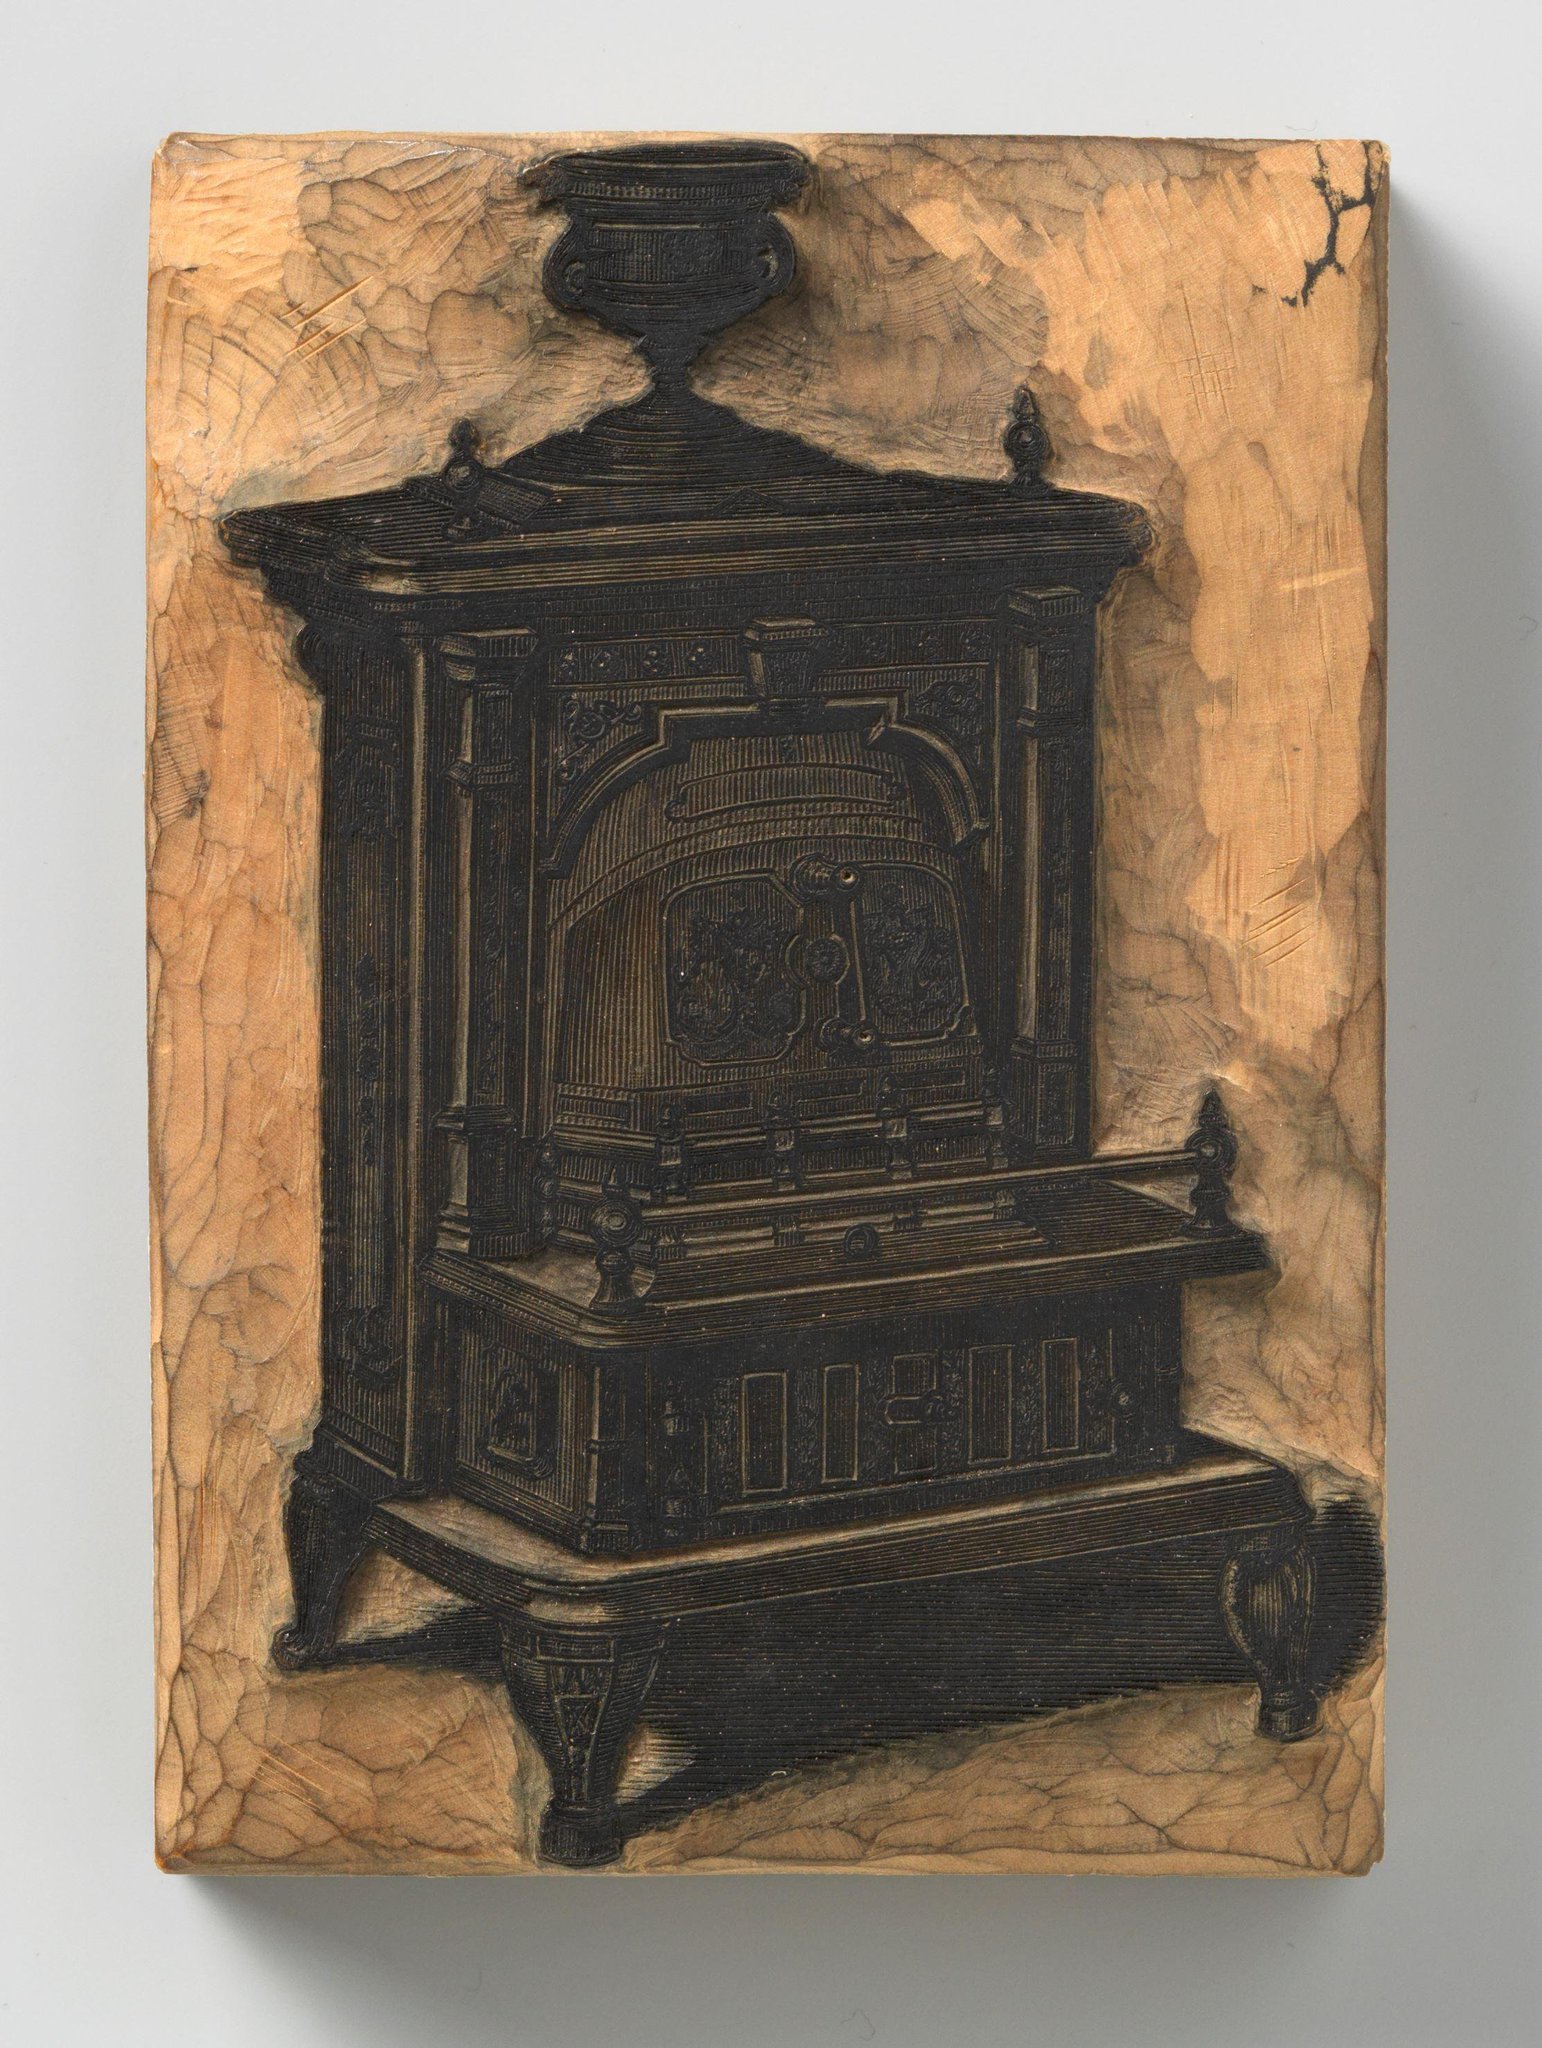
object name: wood block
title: Kachel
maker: Anonymous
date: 1800-1899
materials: wood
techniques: engraving